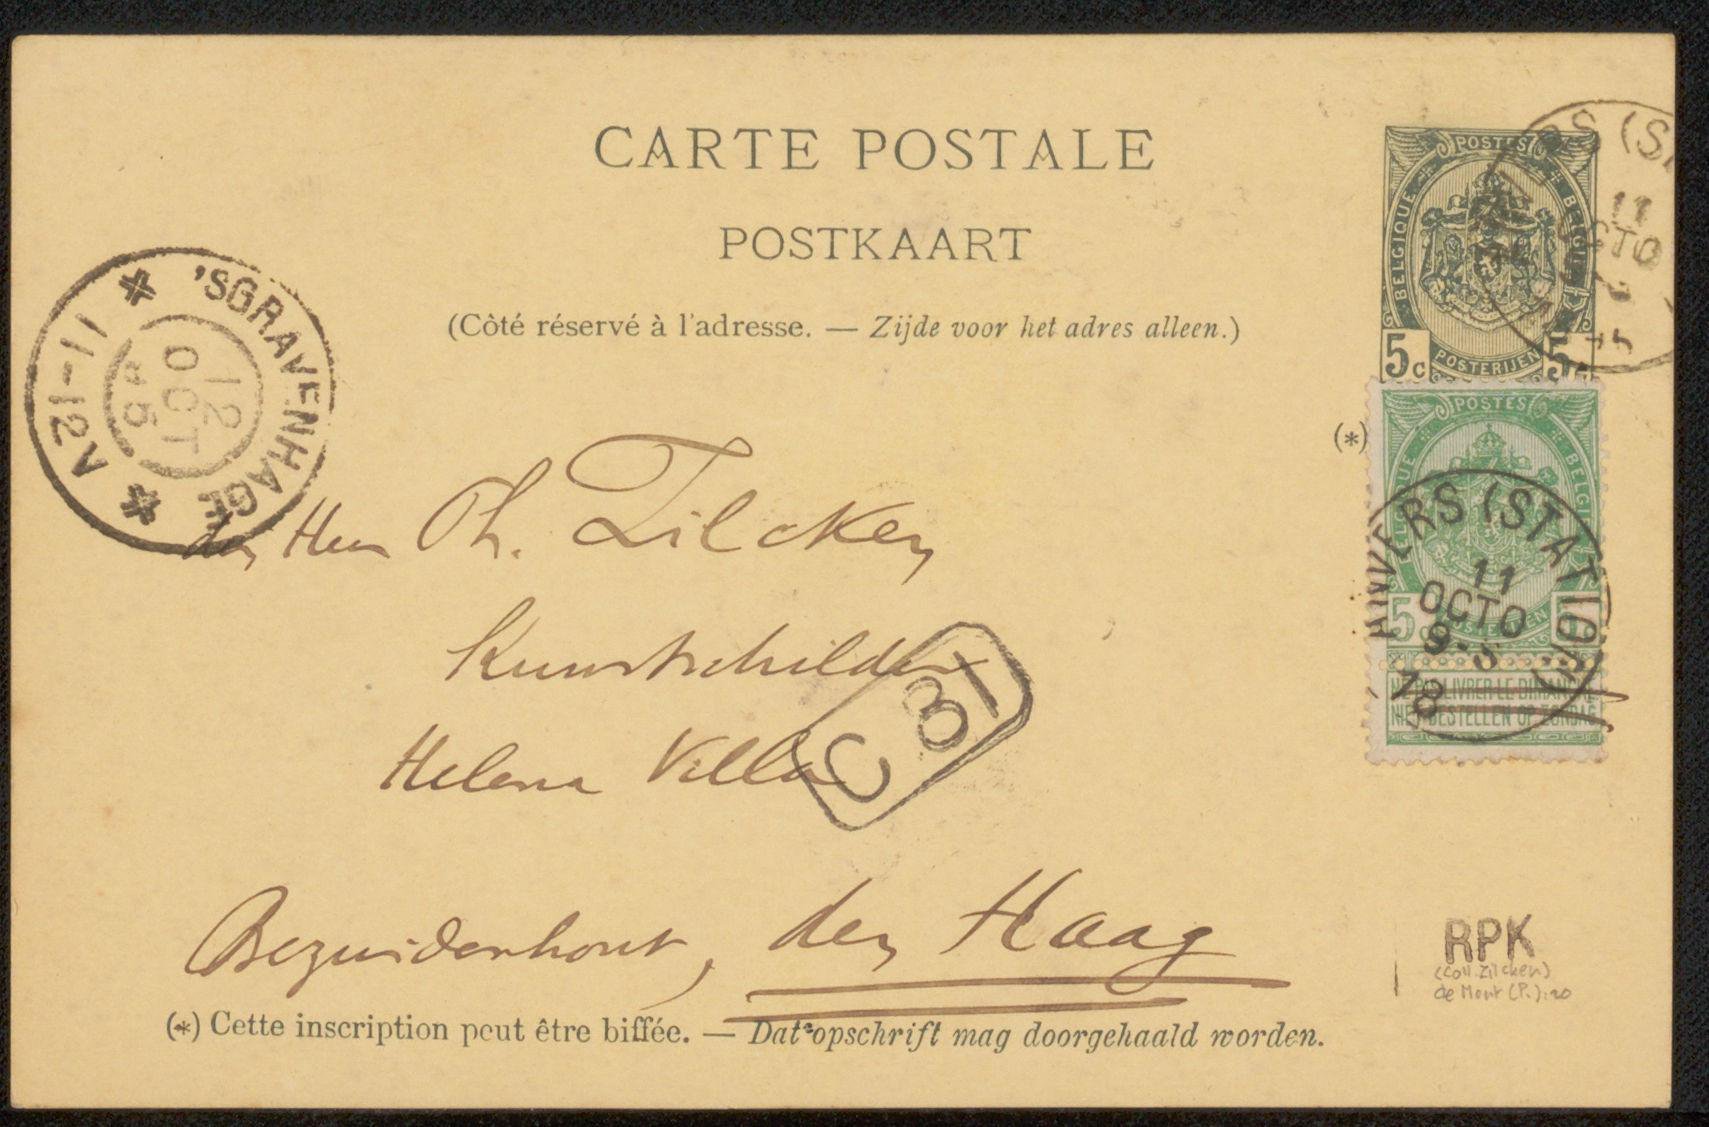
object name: postcard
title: Briefkaart aan Philip Zilcken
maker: pol de mont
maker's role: dichter, prozaschrijver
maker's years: 1857-1931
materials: cardboard, ink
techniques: pen, writing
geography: antwerp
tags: dordrecht, amsterdam, painter, print maker, draughtsman, designer, jan veth, den bosch, antoon derkinderen, jan toorop, the hague, philip zilcken, the graphic arts, historical persons (portraits and scenes from the life)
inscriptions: collector's mark: ‘RPK’